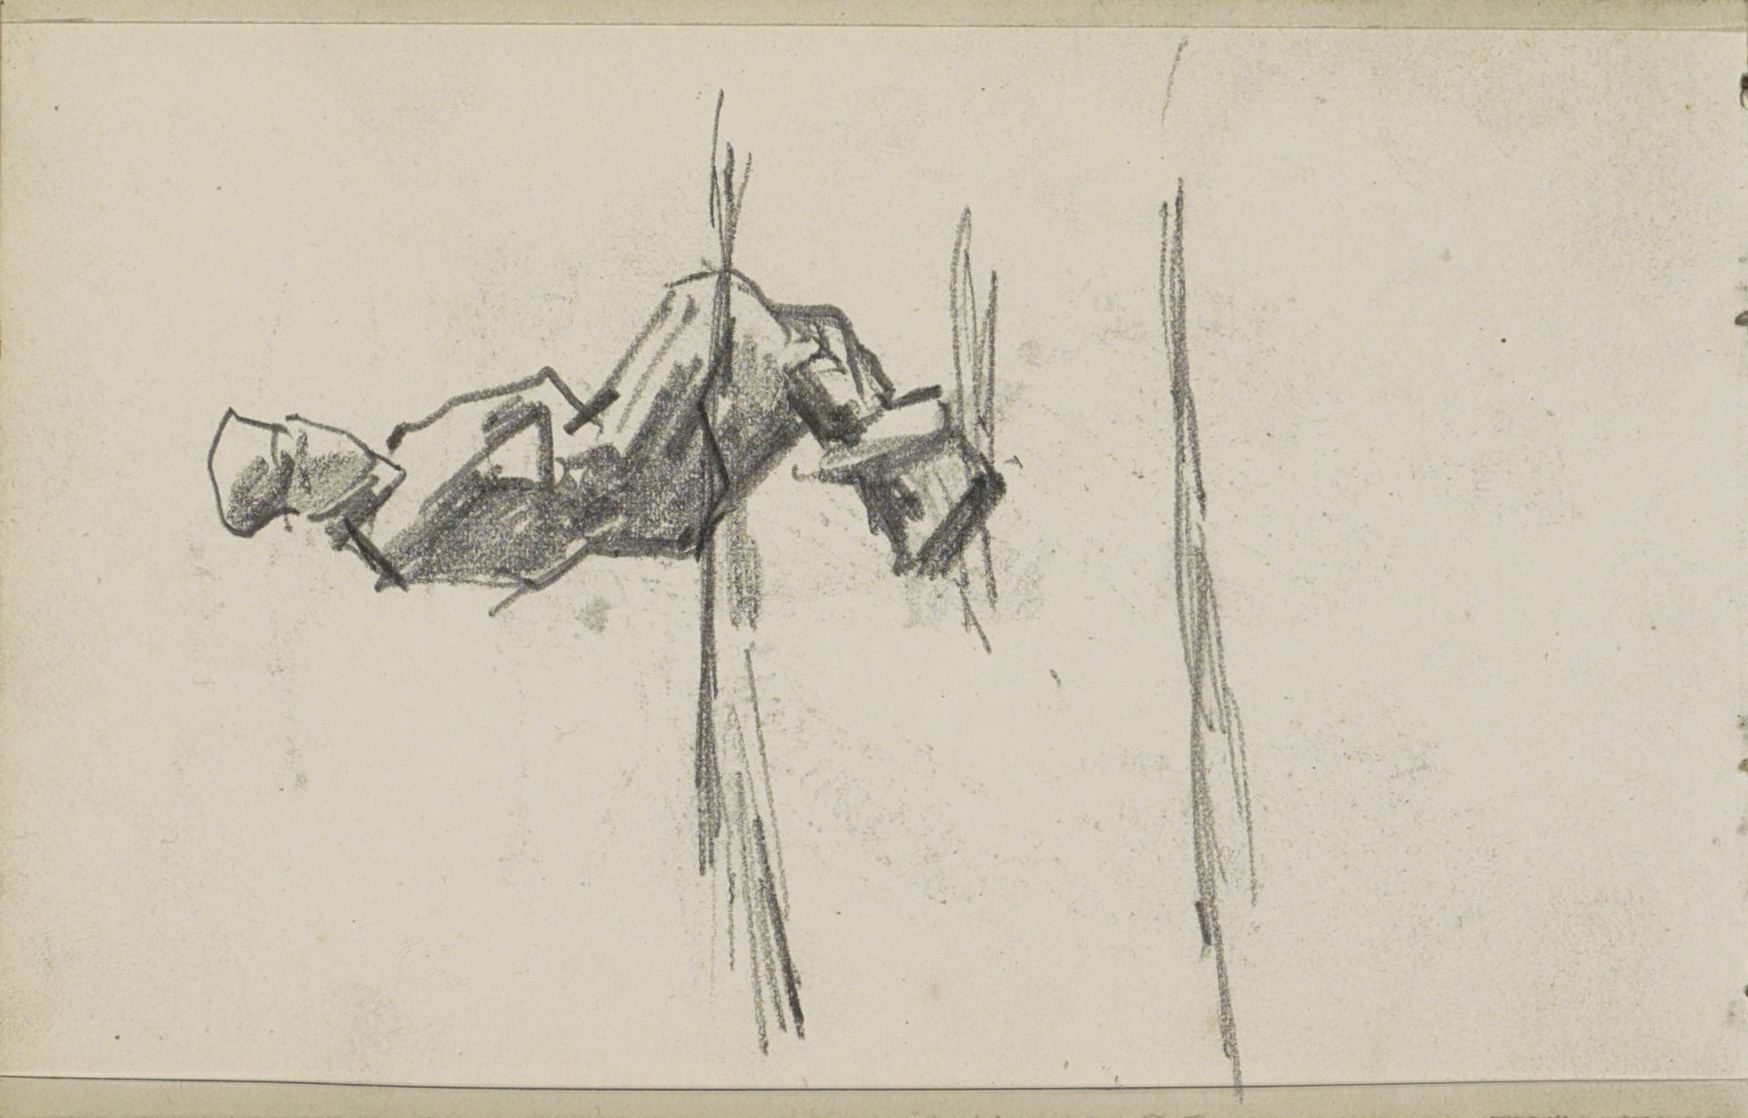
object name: sketchbook leaf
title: Jongen zittend op een muur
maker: george clausen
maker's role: draughtsman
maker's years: 1852-1912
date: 1875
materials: paper, pencil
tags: sitting figure, boy (child between toddler and youth)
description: Blad 22 verso uit een schetsboek met 38 bladen.